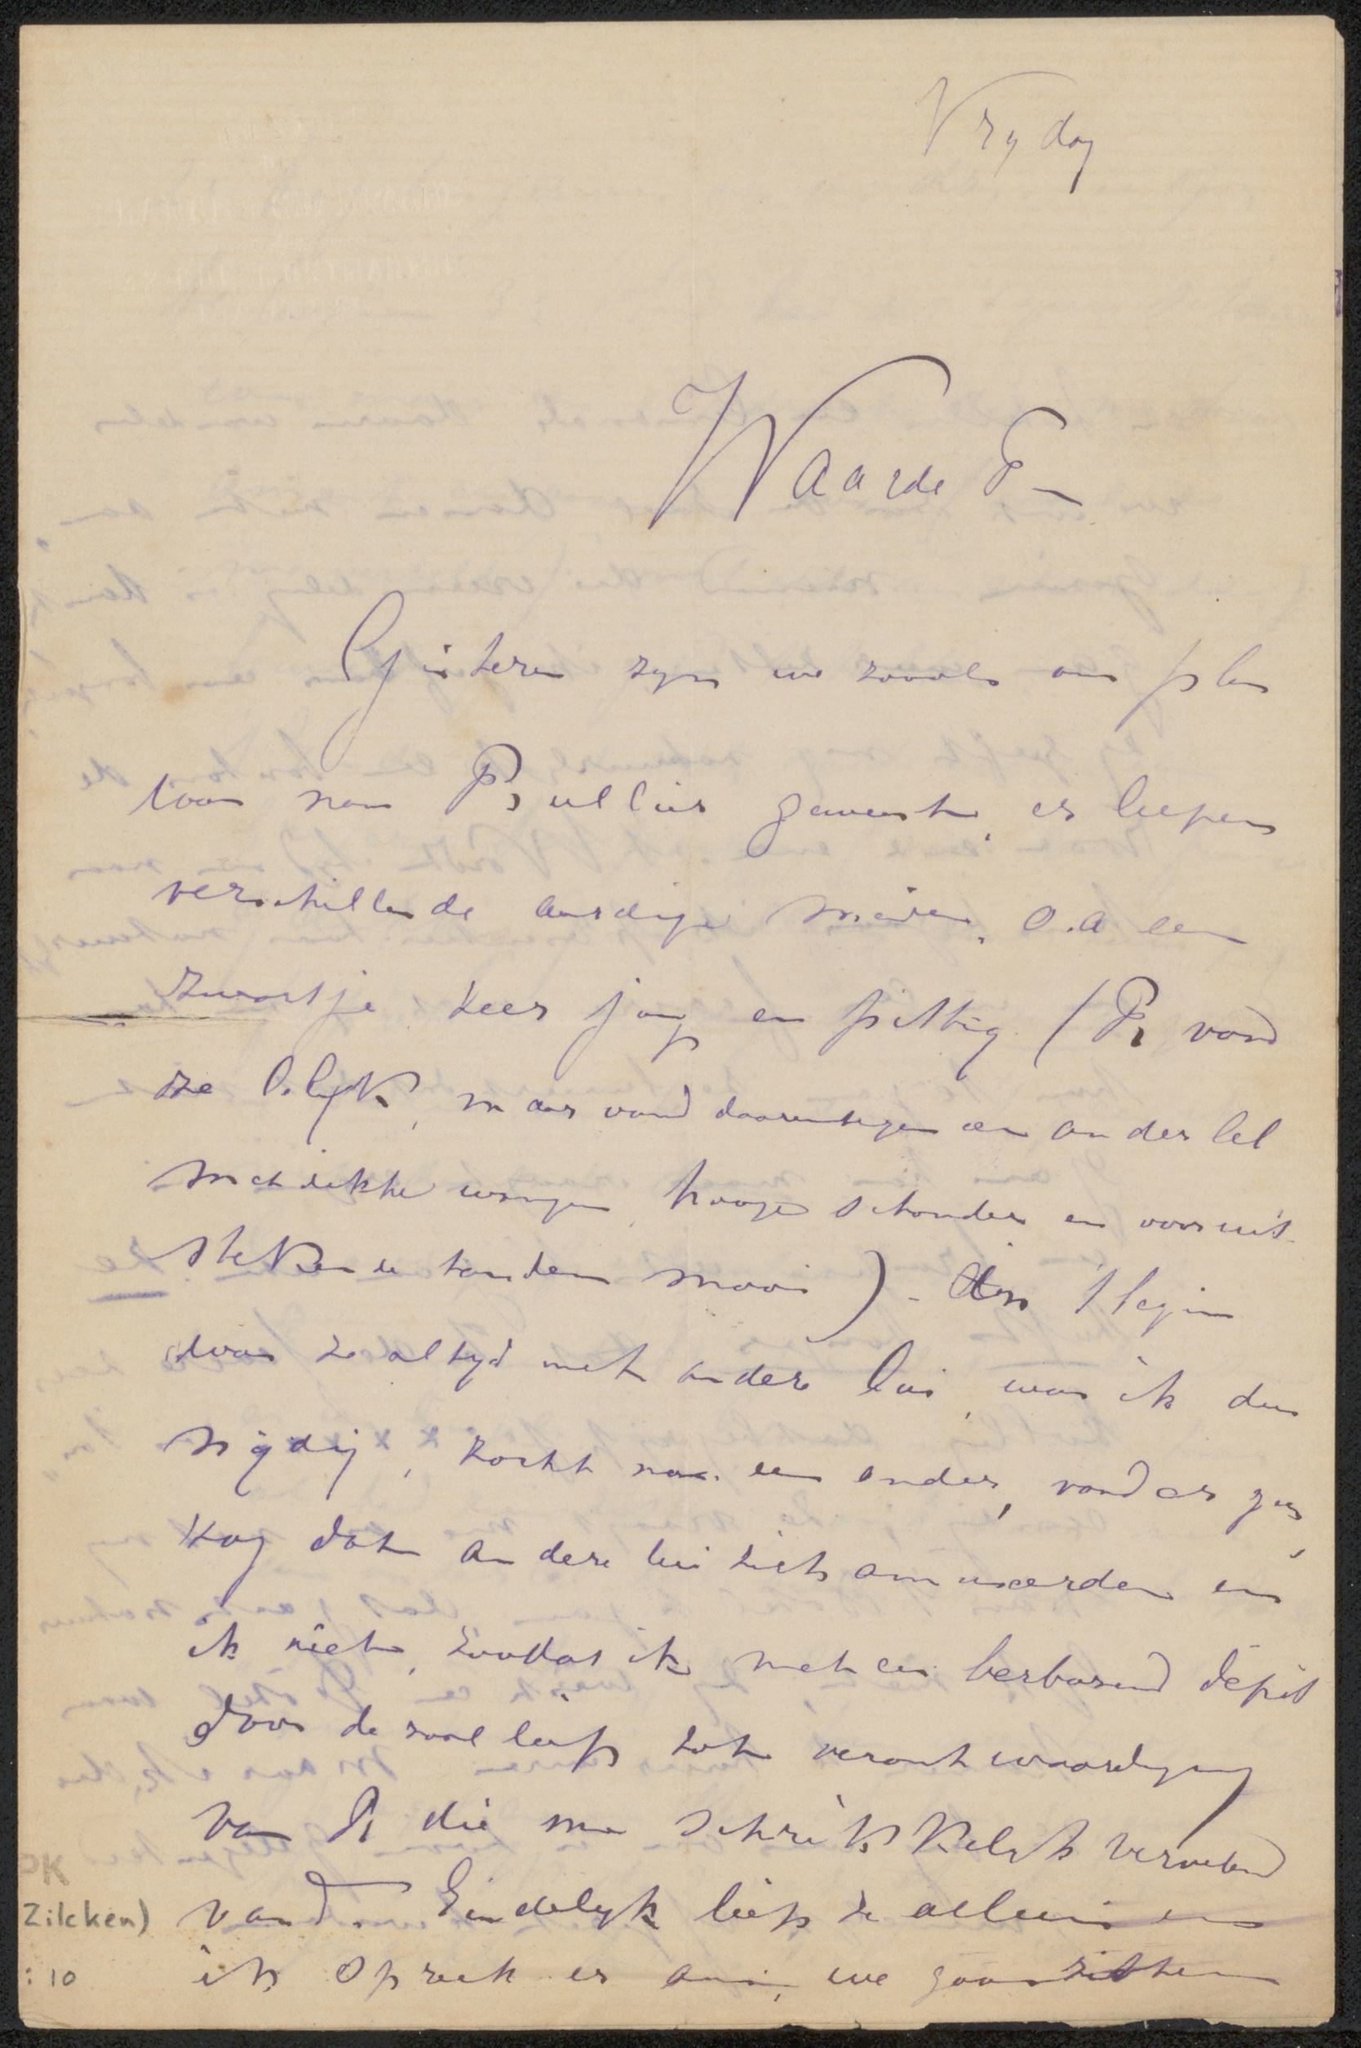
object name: letter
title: Brief aan Philip Zilcken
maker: adriaan pit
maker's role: print maker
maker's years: 1860-1944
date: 1870-1930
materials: ink, paper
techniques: pen, writing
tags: painter, philip zilcken, passions, emotions, affections, paris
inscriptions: watermark, collector's mark: ‘RPK’